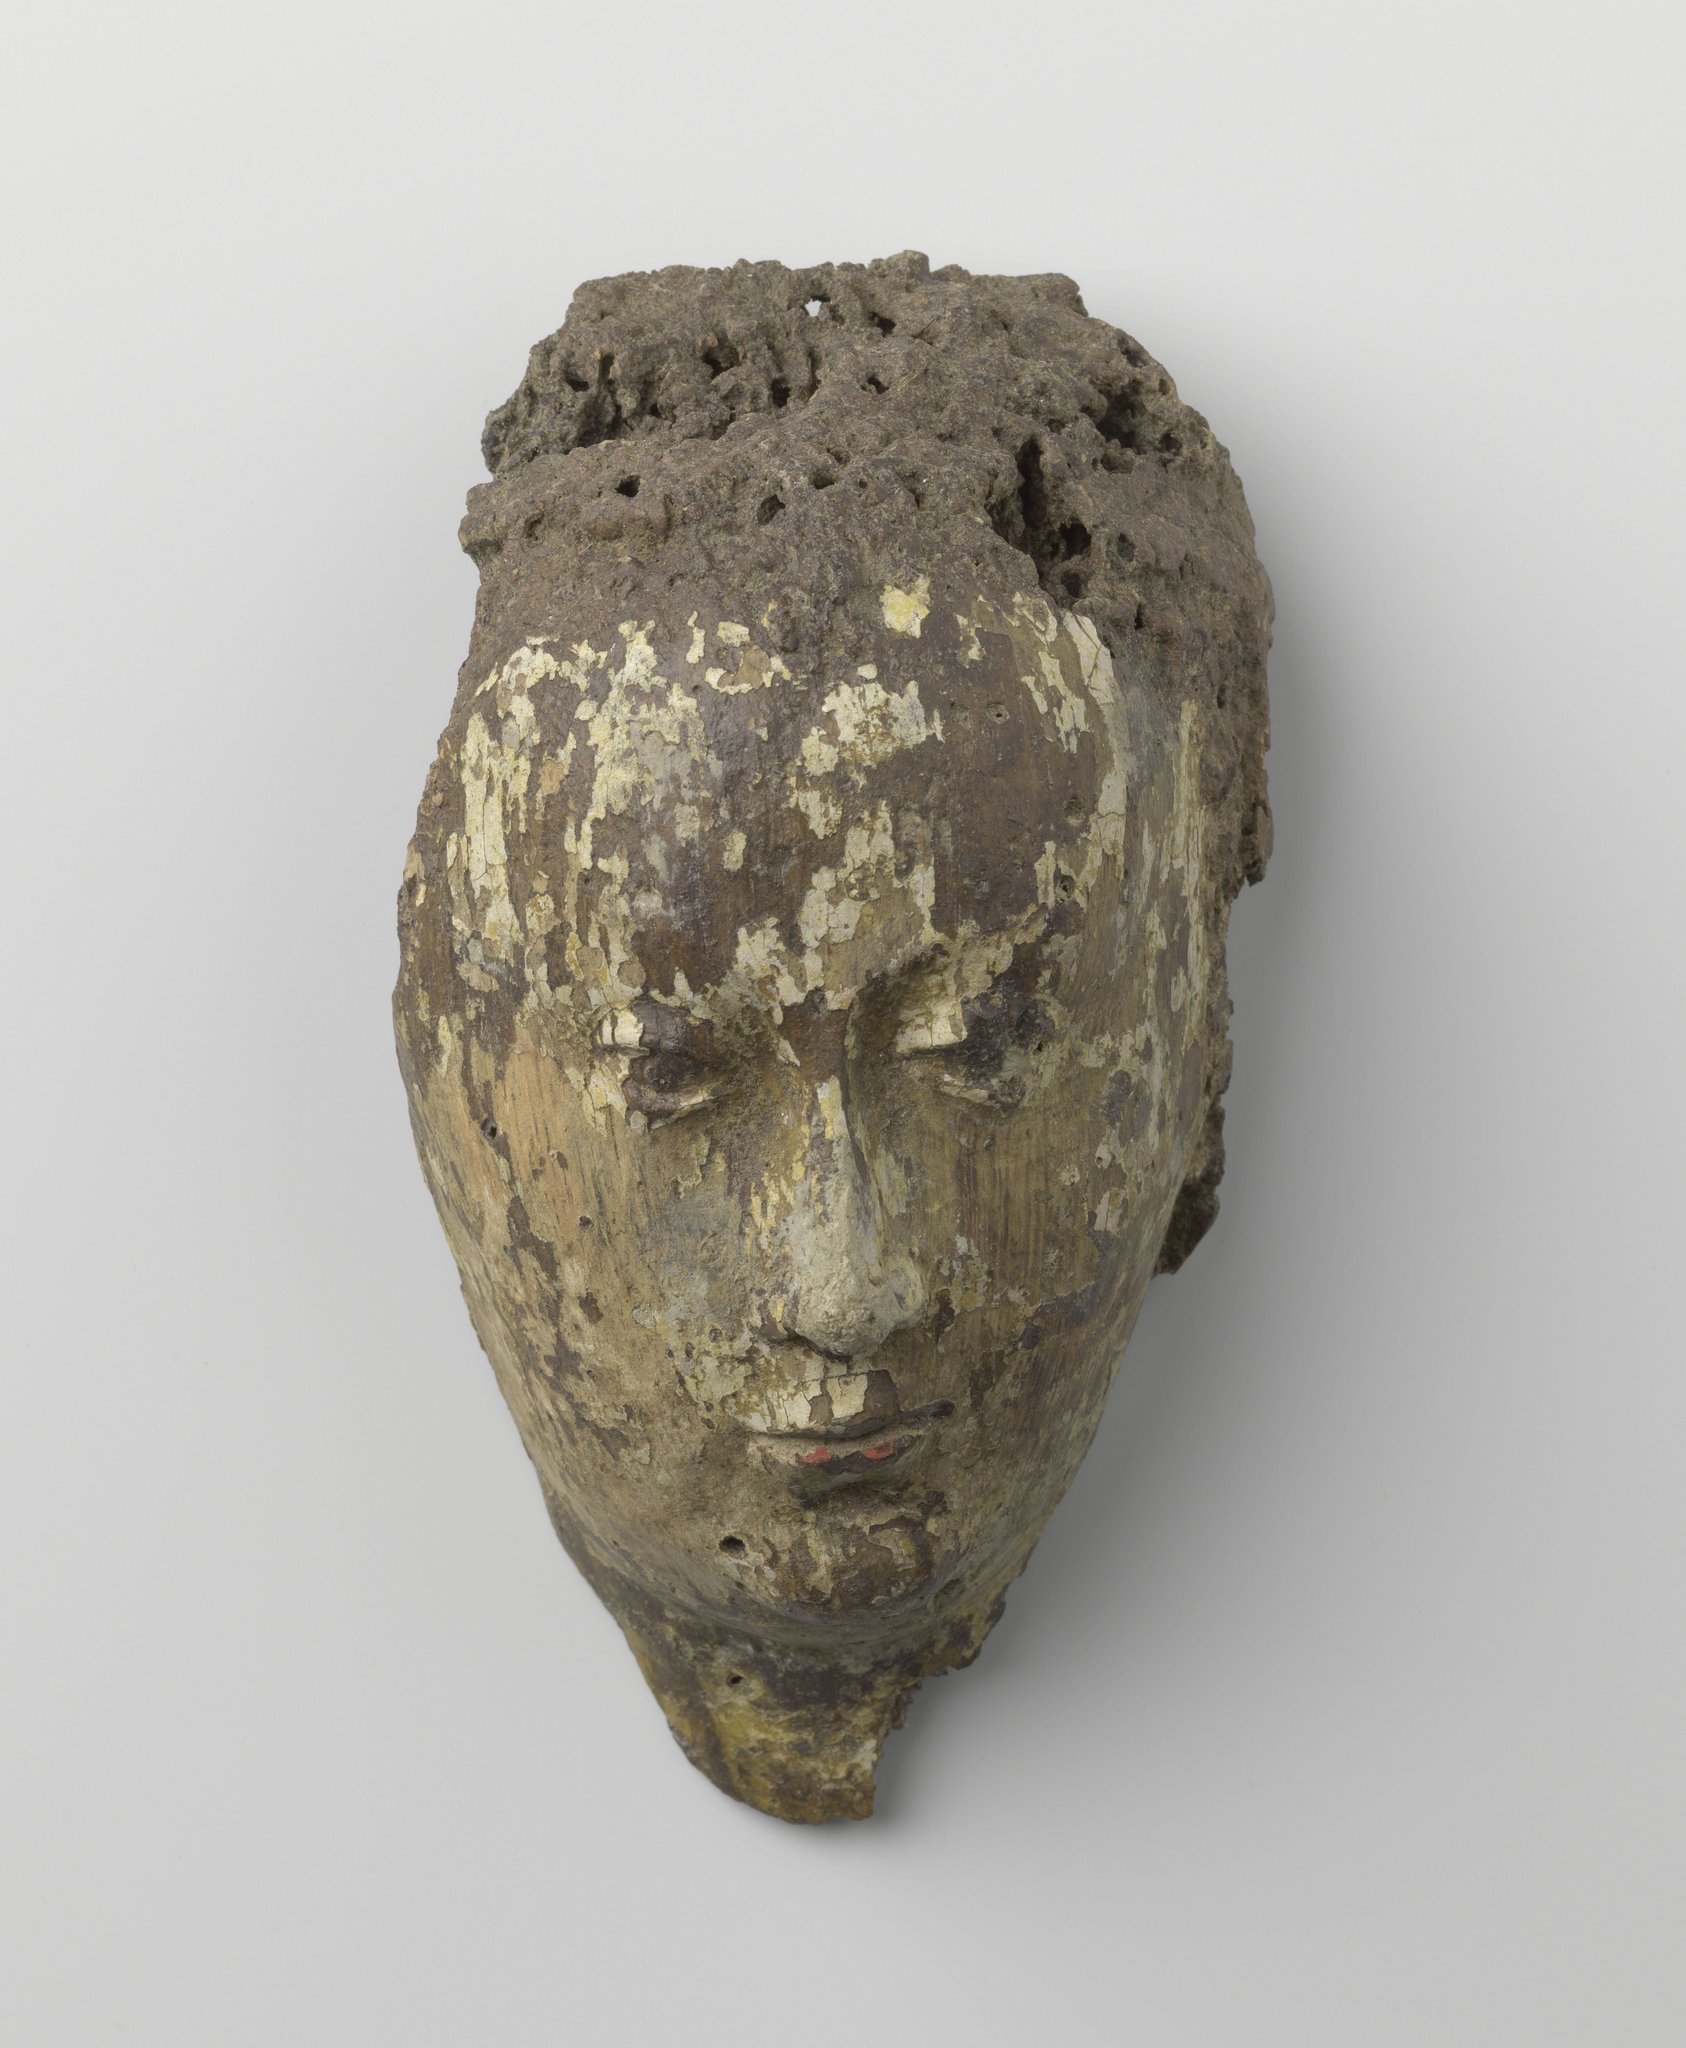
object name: fragment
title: Fragment van het hoofd van een vrouw; (mogelijk) behorend tot het retabel van Soest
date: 1475-1499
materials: wood